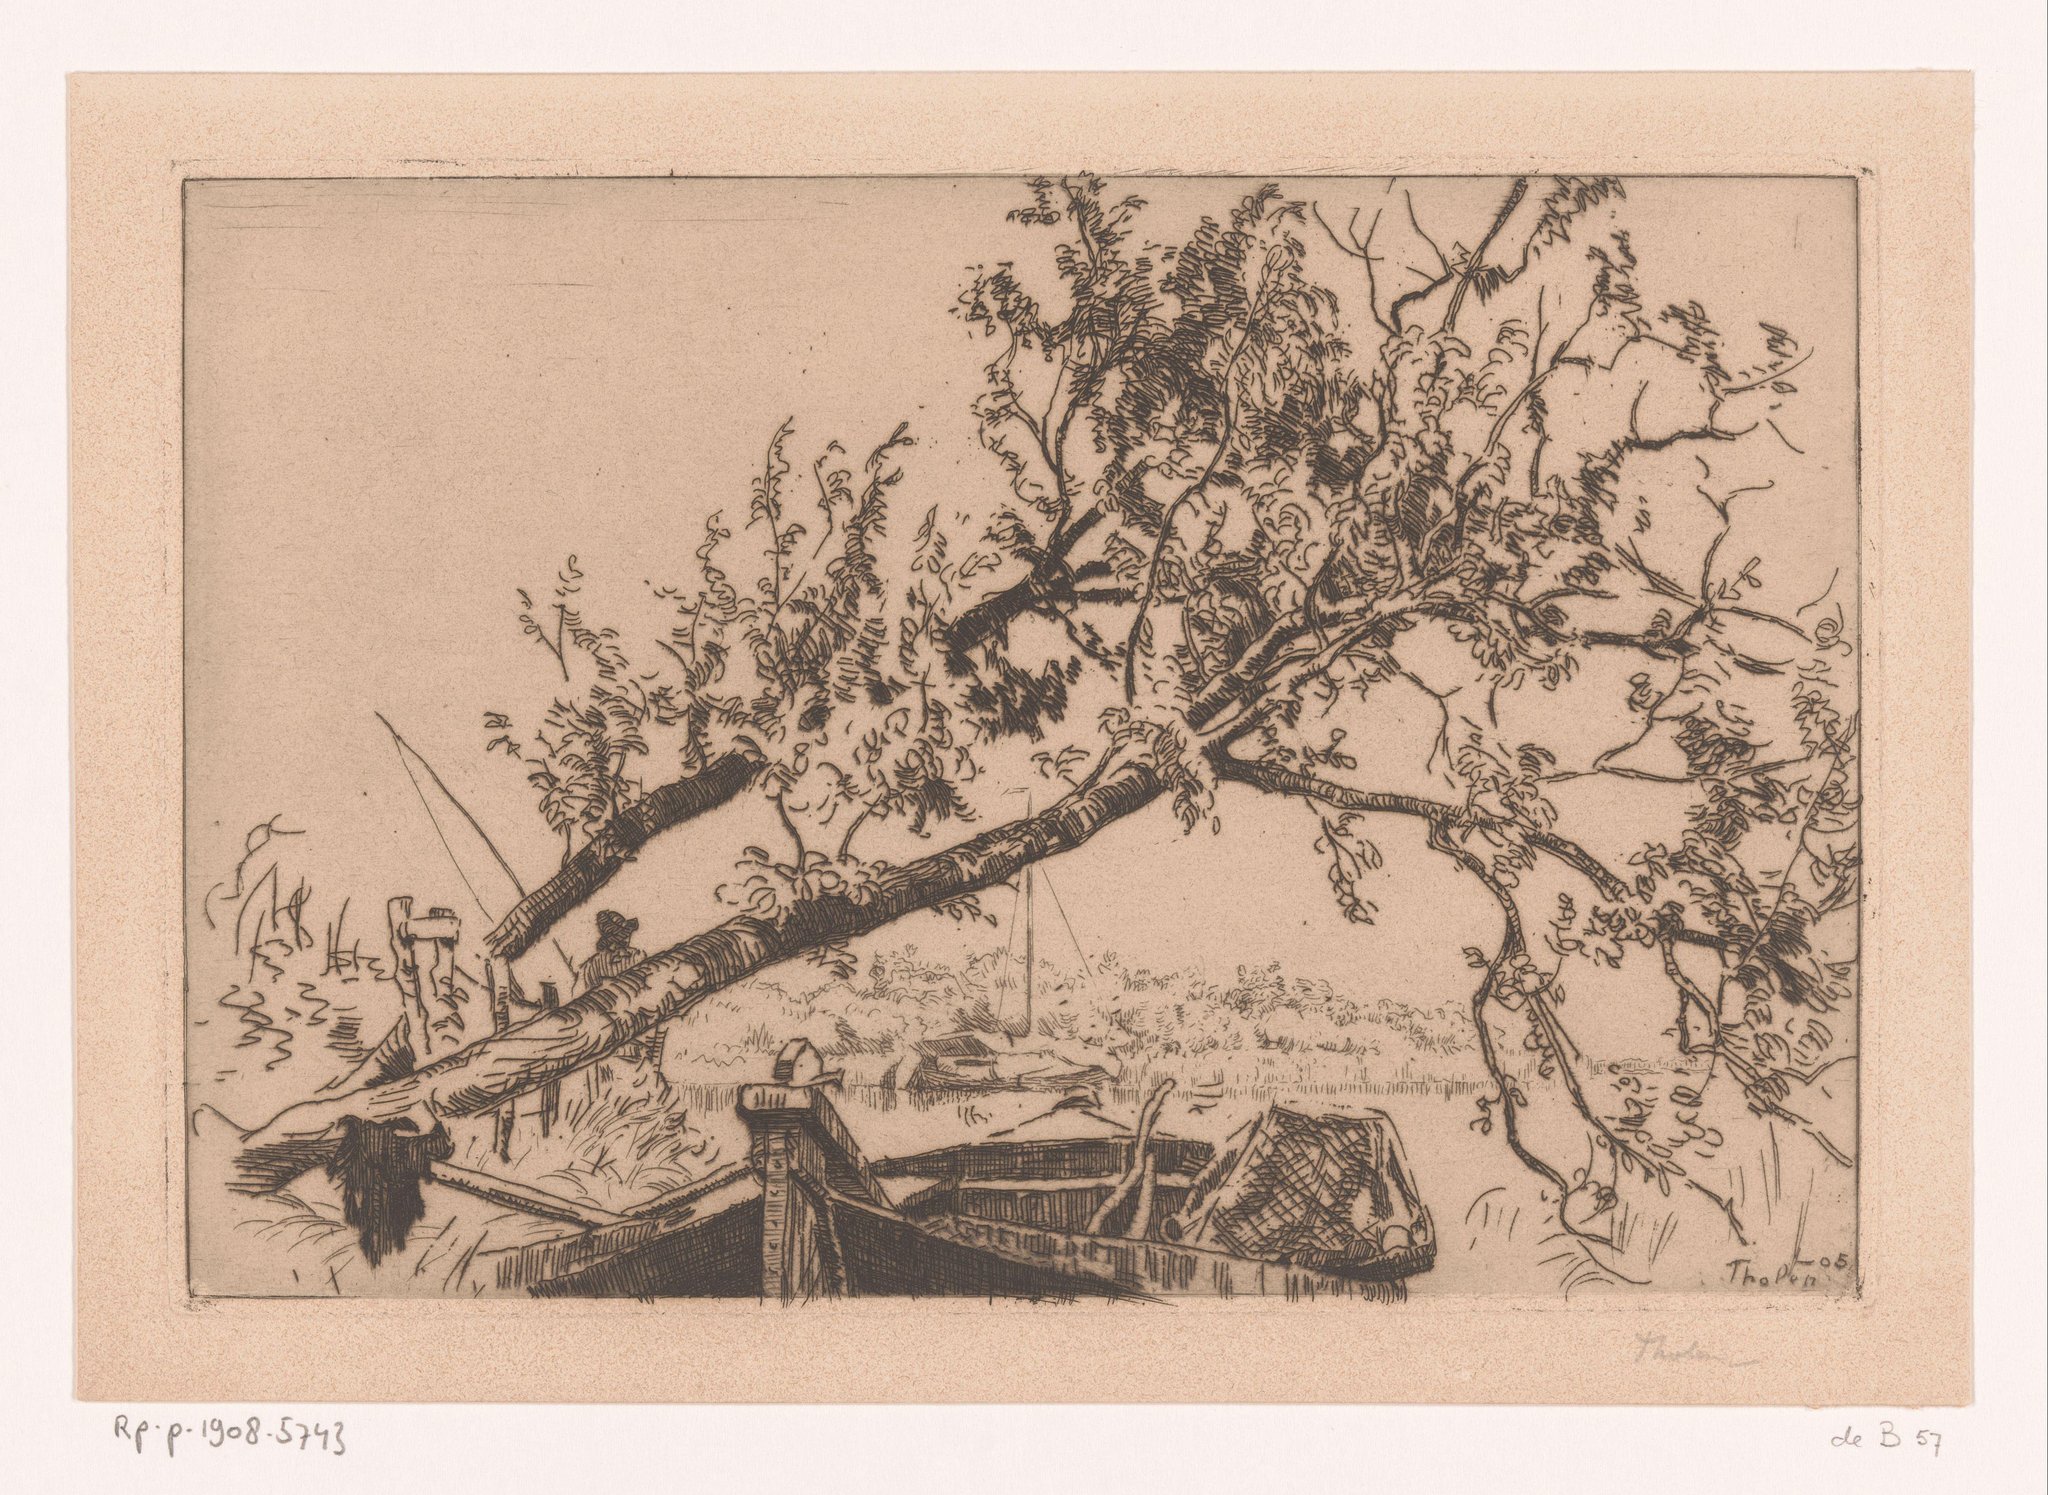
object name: print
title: Landschap met omgevallen boom, boten en hengelaar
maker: willem bastiaan tholen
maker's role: draughtsman, painter, print maker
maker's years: 1860-1931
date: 1905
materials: paper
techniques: etching, intaglio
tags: sailing-ship, sailing-boat, fisherman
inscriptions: collector's mark: Lugt 2228